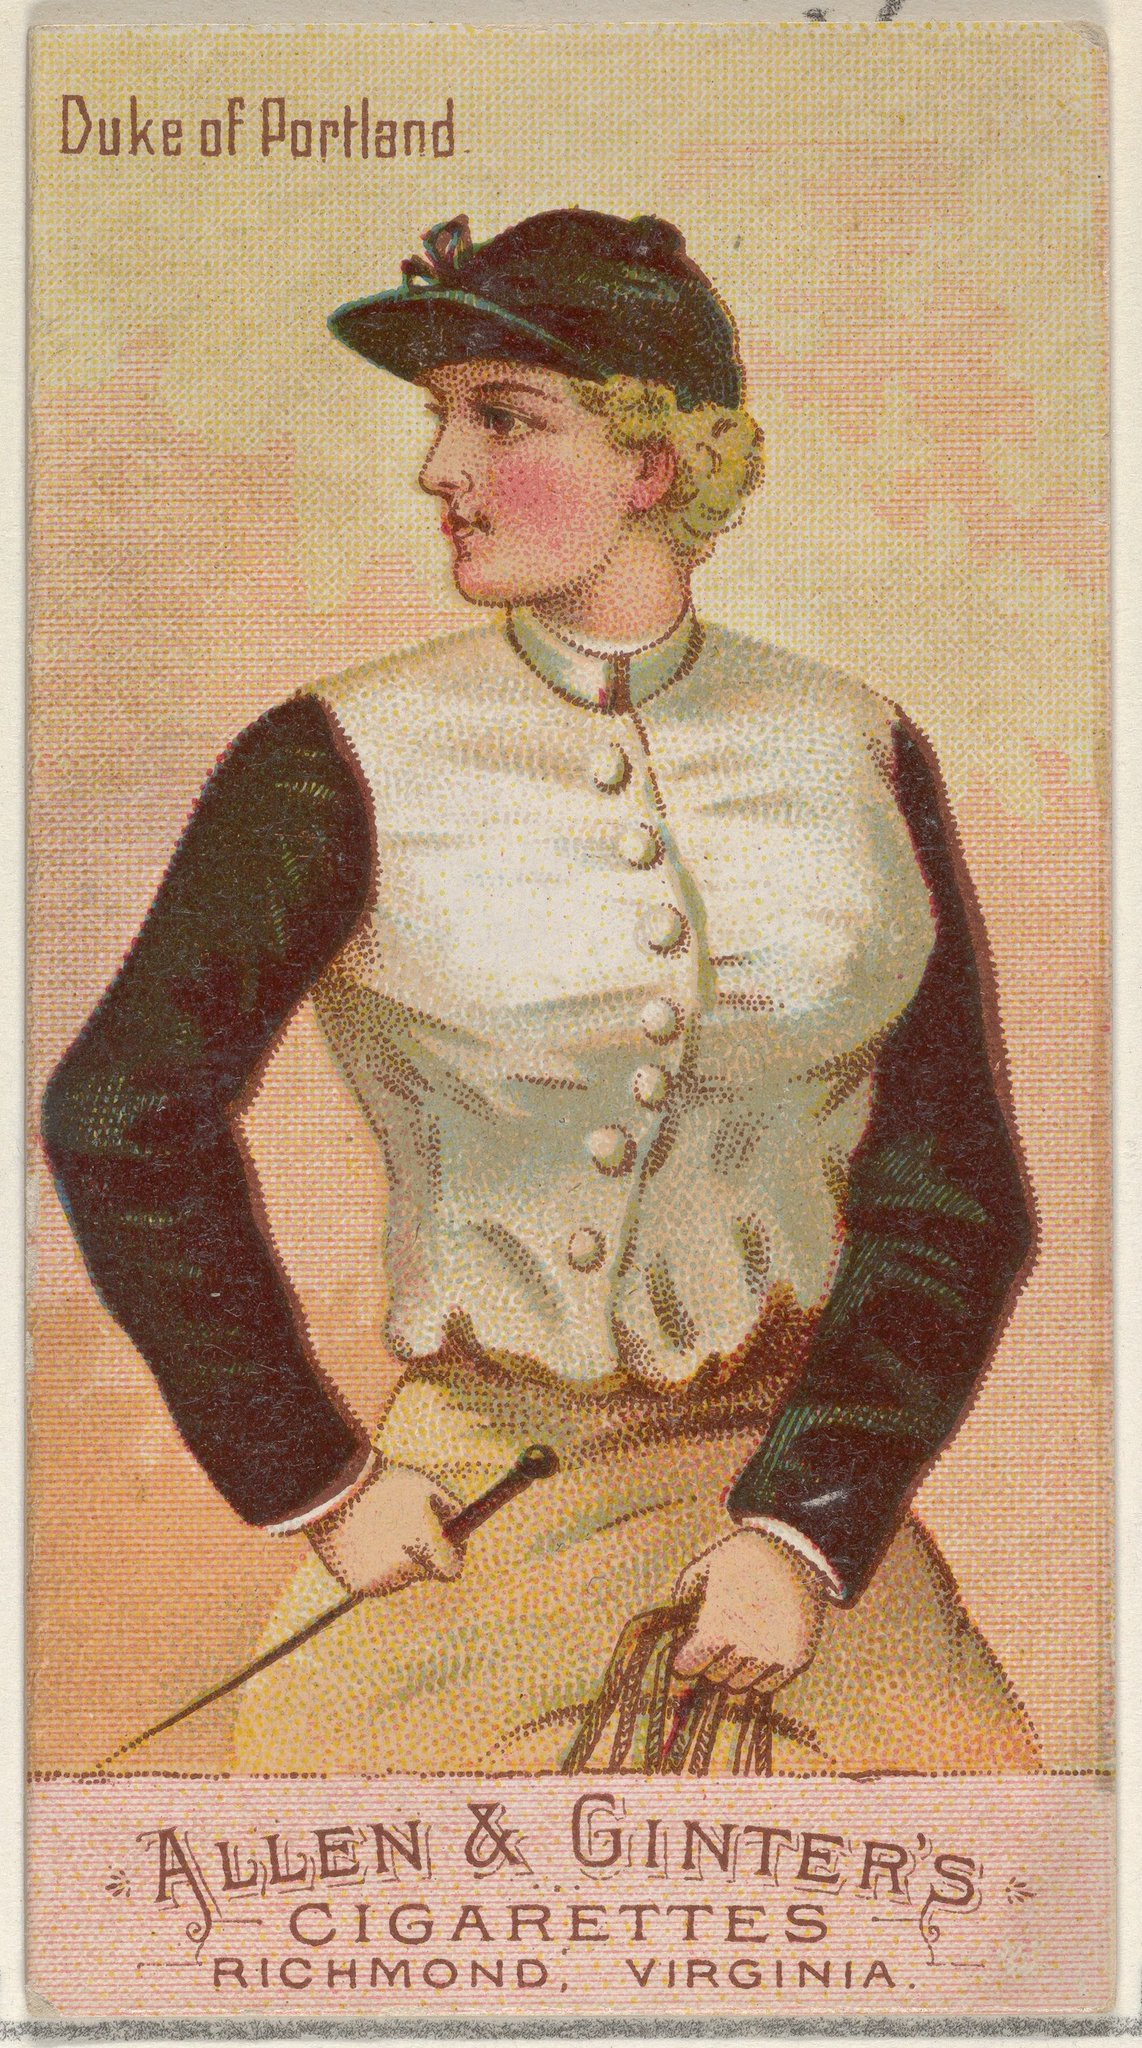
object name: print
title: Duke of Portland, from the Racing Colors of the World series (N22b) for Allen & Ginter Cigarettes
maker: allen & ginter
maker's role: publisher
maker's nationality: american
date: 1888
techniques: color lithograph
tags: women,jockeys